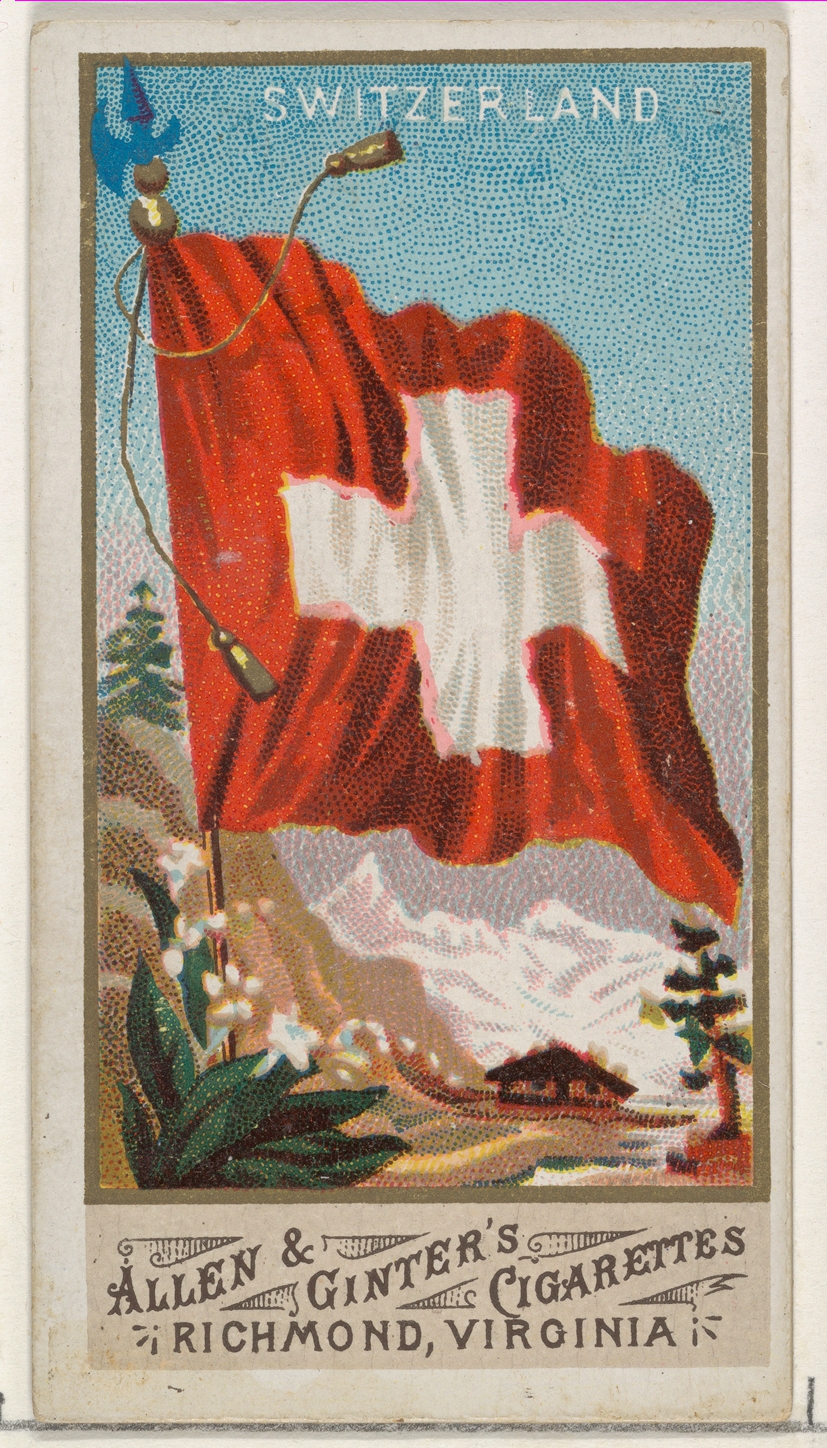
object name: print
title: Switzerland, from Flags of All Nations, Series 1 (N9) for Allen & Ginter Cigarettes Brands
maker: allen & ginter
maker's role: publisher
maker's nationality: american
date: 1887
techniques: color lithograph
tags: flags